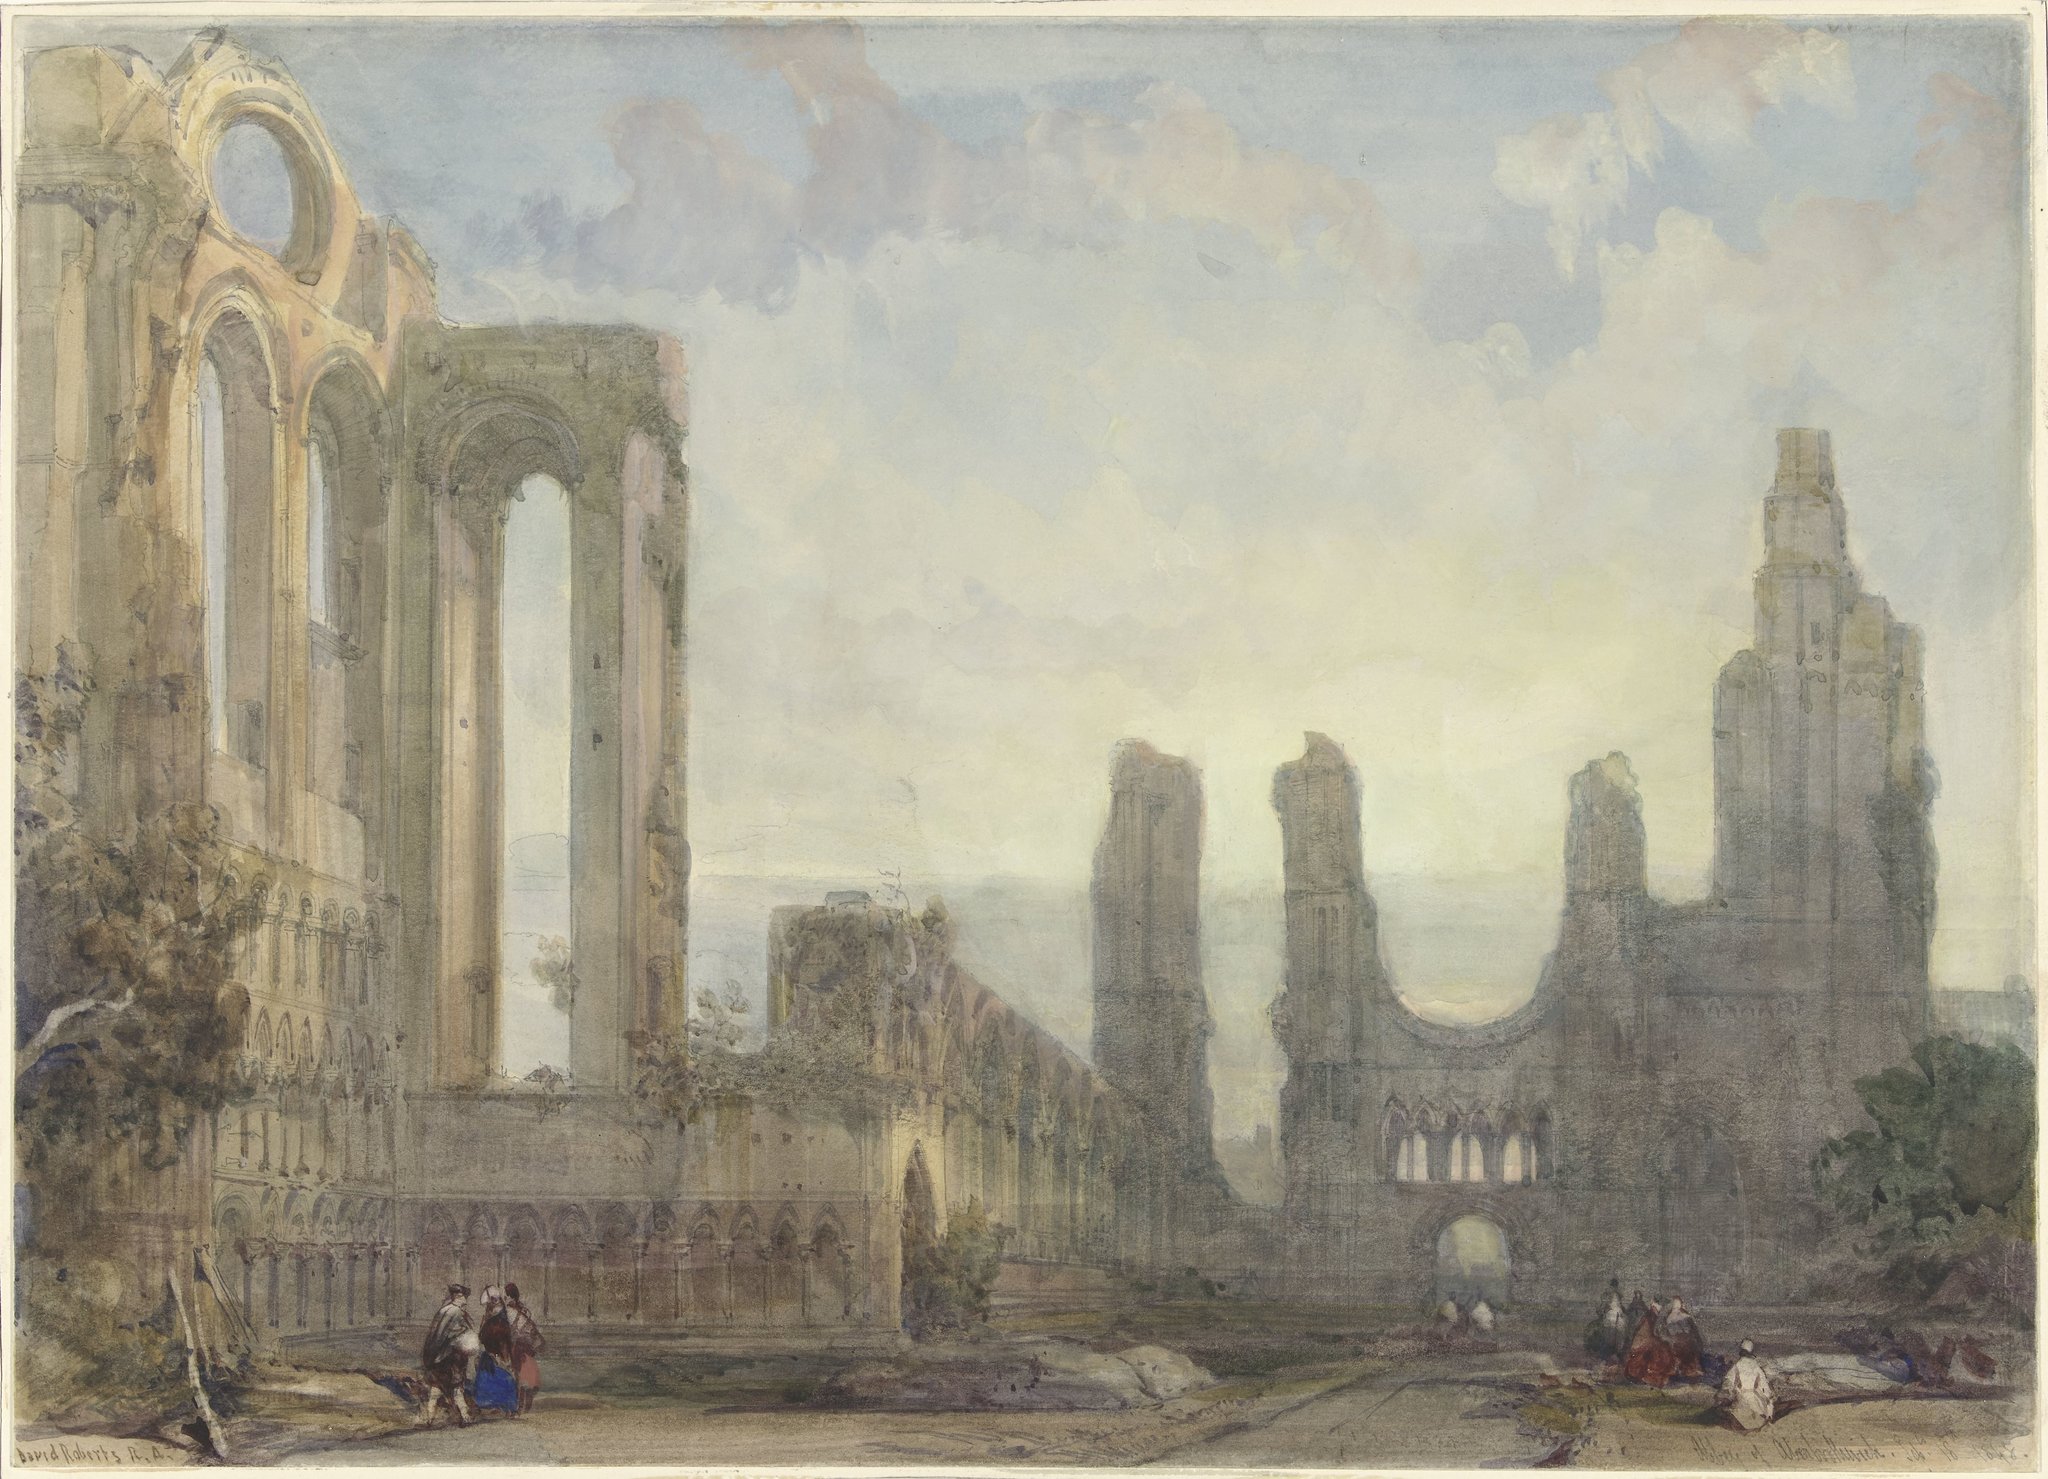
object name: drawing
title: Abdijruïne van Aberbrothwick bij avond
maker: david roberts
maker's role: draughtsman, painter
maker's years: 1796-1864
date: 1848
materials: paper, pencil, watercolor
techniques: brush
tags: abbey, monastery, convent ~ roman catholic church, landscape with ruins (+ city(-scape) with figures, staffage)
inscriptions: inscription: ‘Abbey of Aberbrothwick’